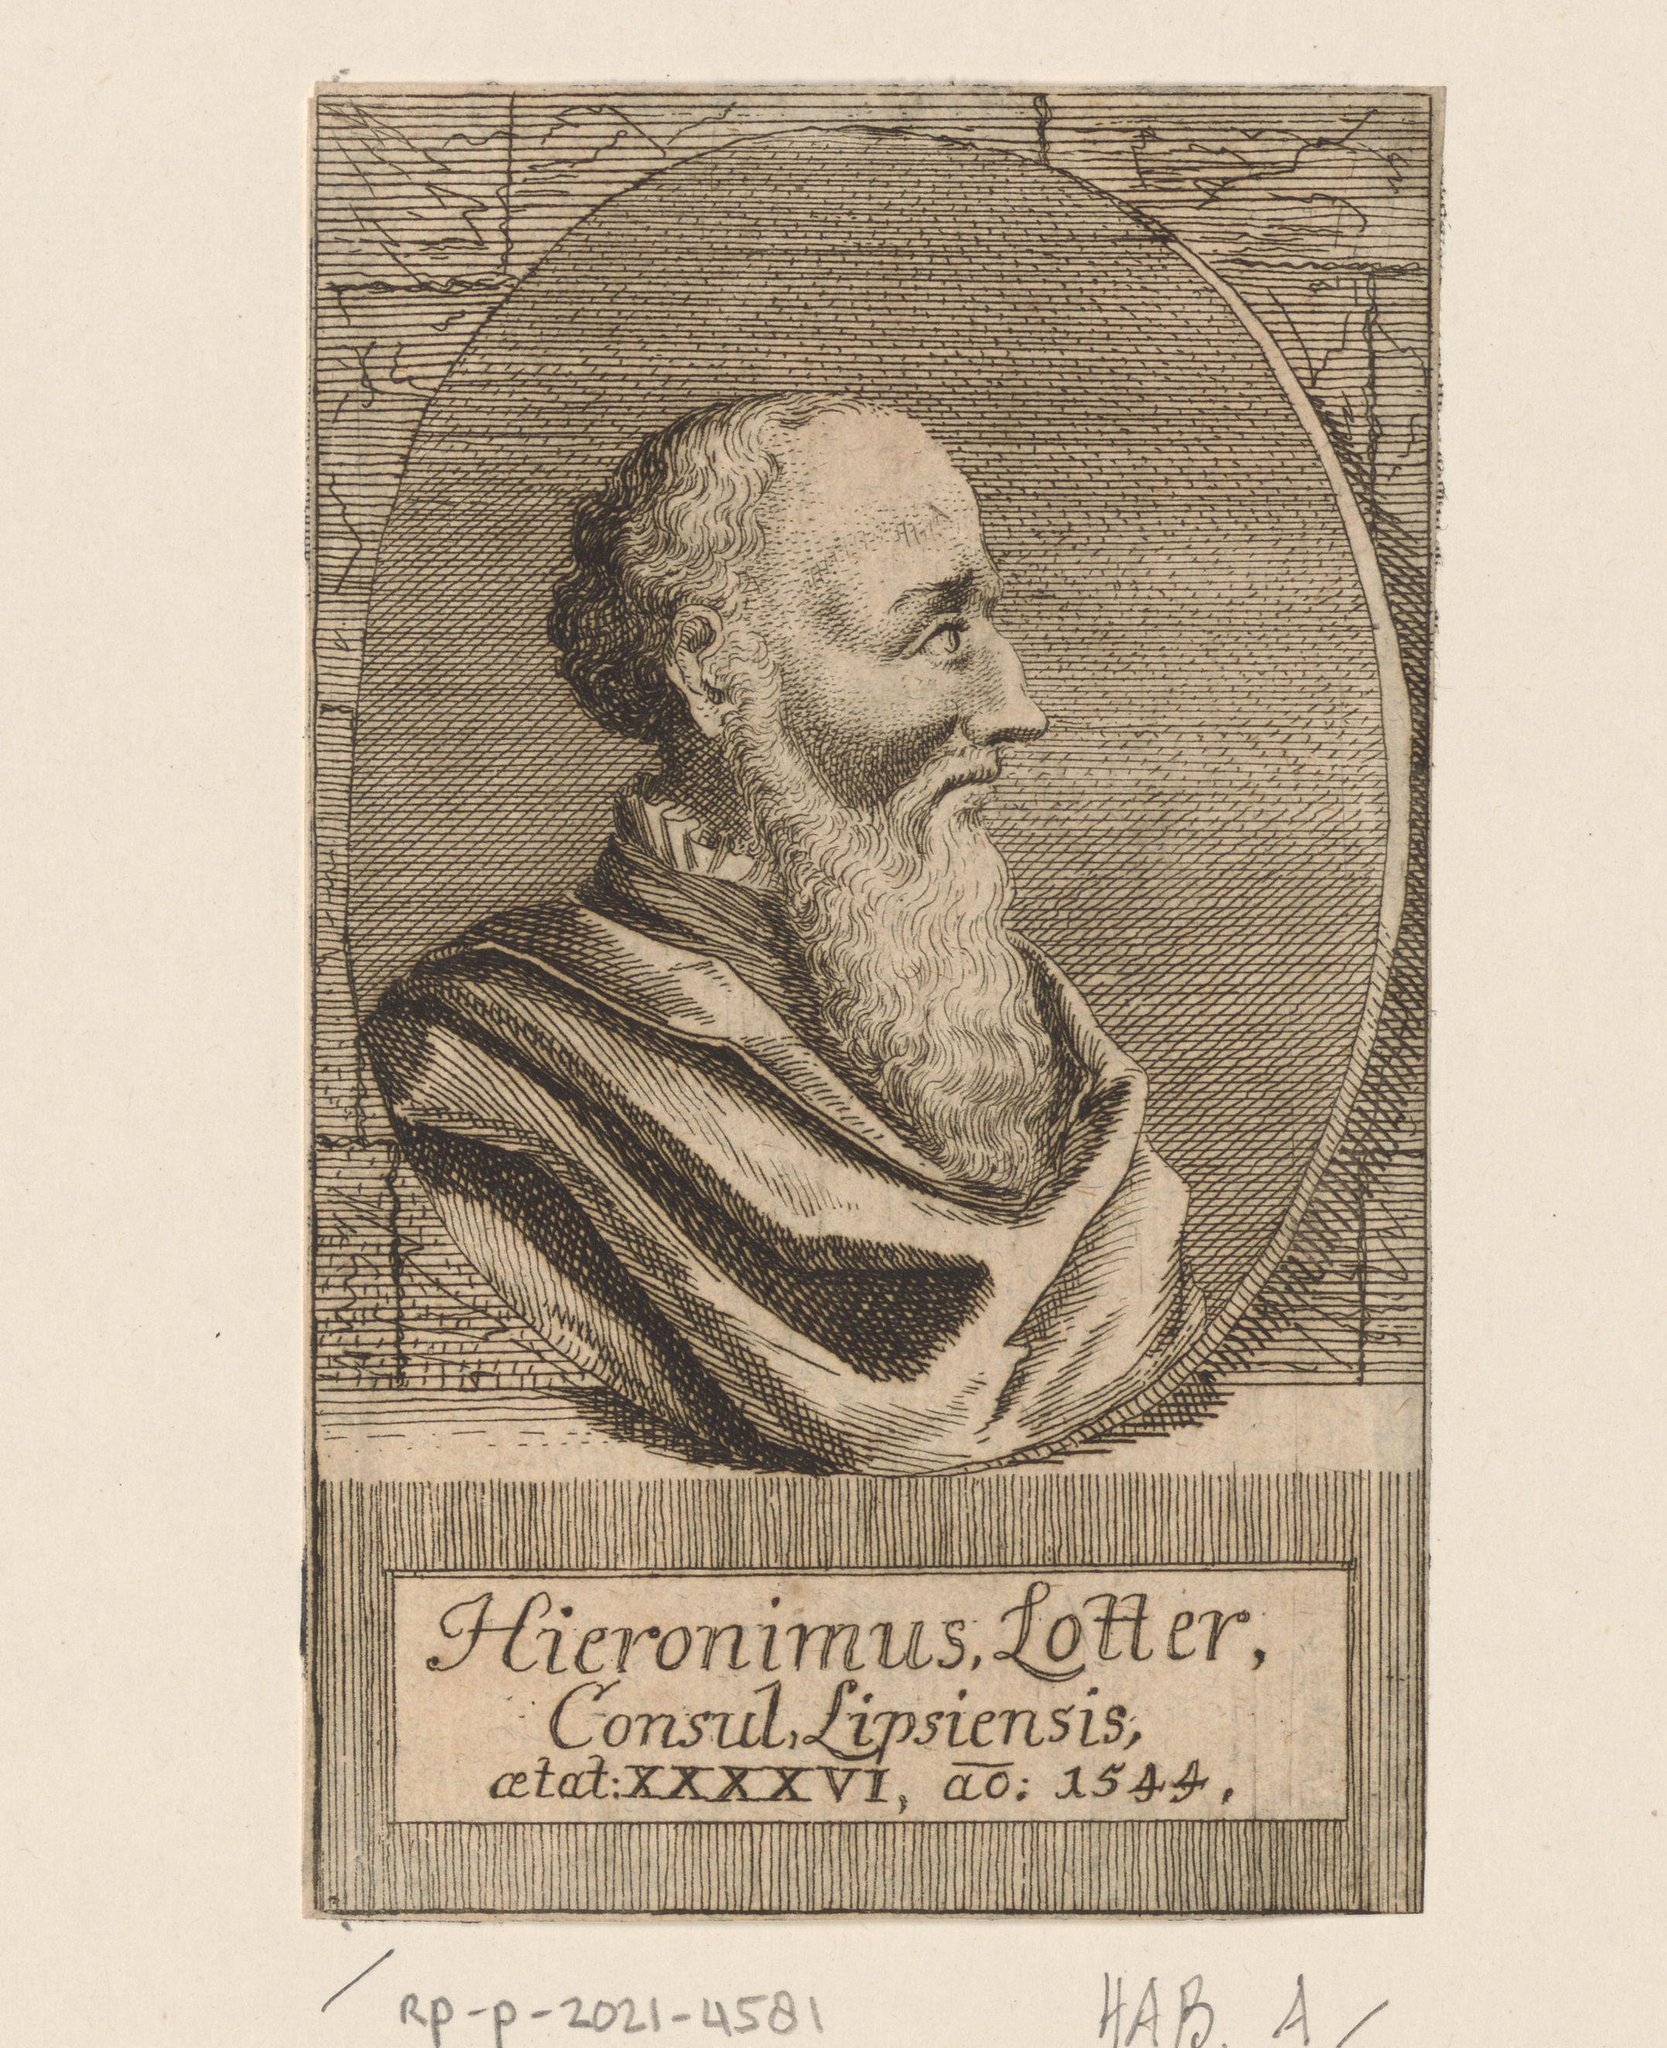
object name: print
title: Portret van Hieronymus Lotter op 46-jarige leeftijd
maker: Anonymous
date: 1700-1799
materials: paper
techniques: etching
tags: ornament ~ medallion, historical persons, politician, e.g. party leader